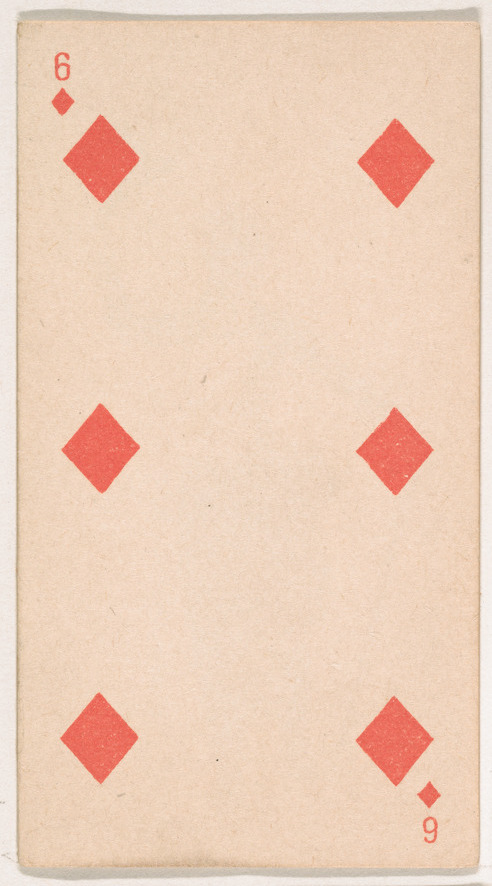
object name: print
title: Six of Diamonds, from the Transparent Playing Cards series (N220) issued by Kinney Bros.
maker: kinney brothers tobacco company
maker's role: publisher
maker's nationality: american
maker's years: 1869-2011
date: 1888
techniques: color lithograph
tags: playing cards